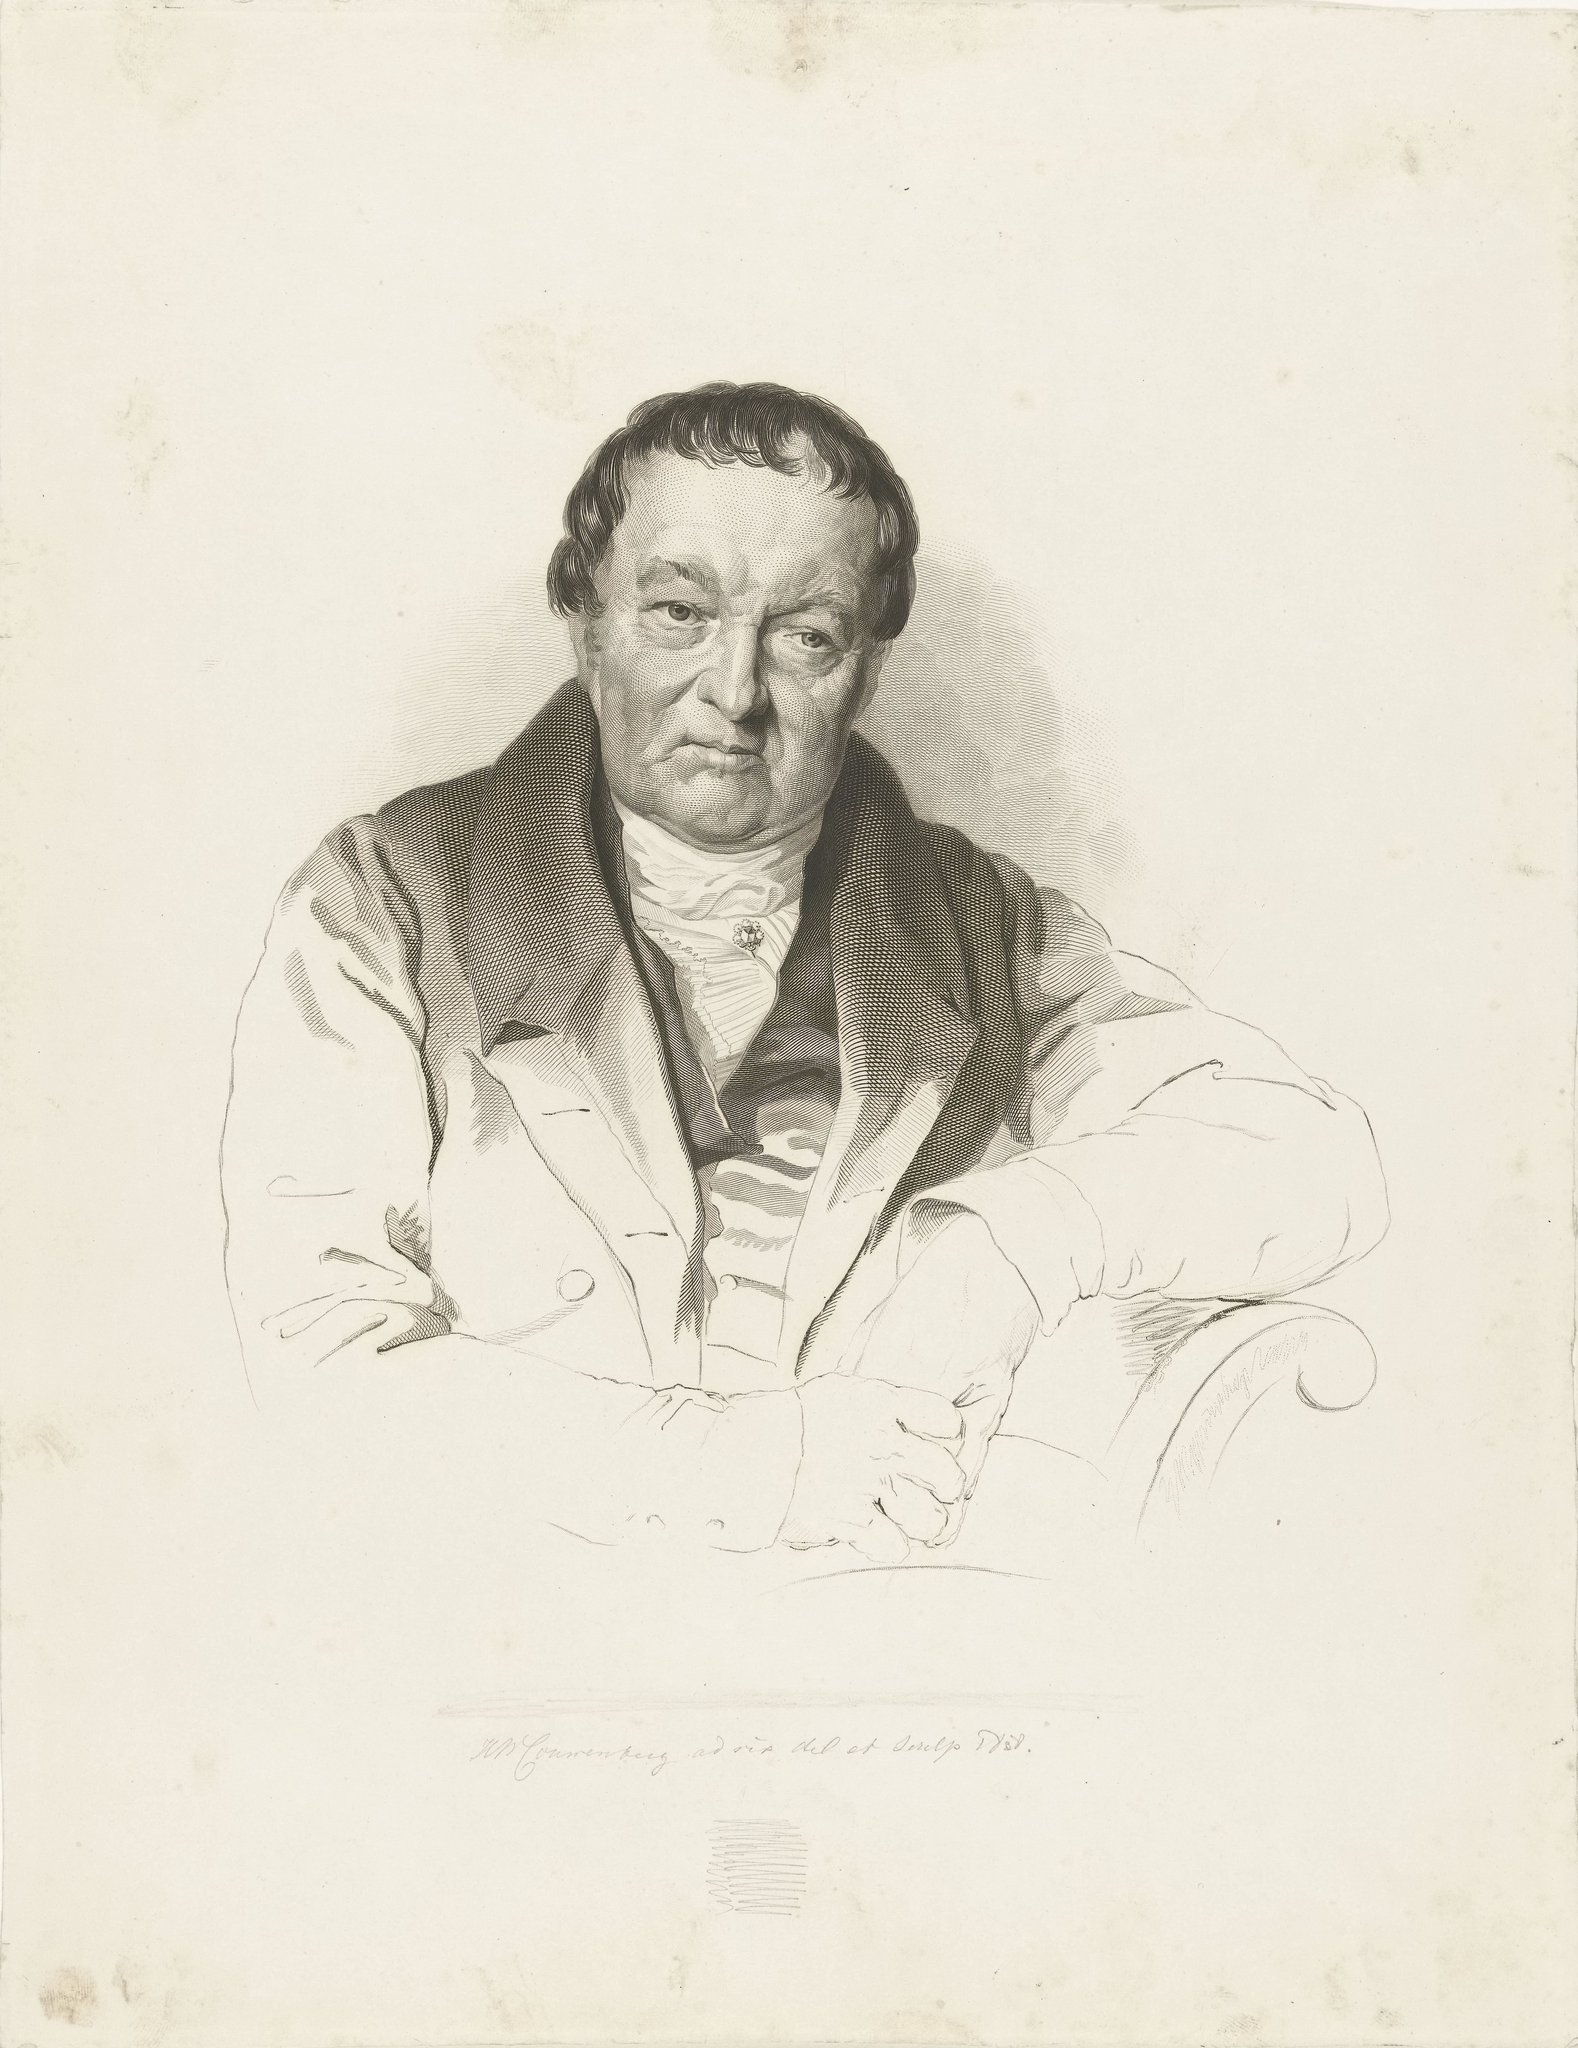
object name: print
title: Portret van de kunstverzamelaar Louis Splitgerber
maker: henricus wilhelmus couwenberg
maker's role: draughtsman, print maker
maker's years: 1814-1845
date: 1838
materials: paper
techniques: engraving, roulette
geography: amsterdam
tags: art collector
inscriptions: collector's mark: Lugt 2228